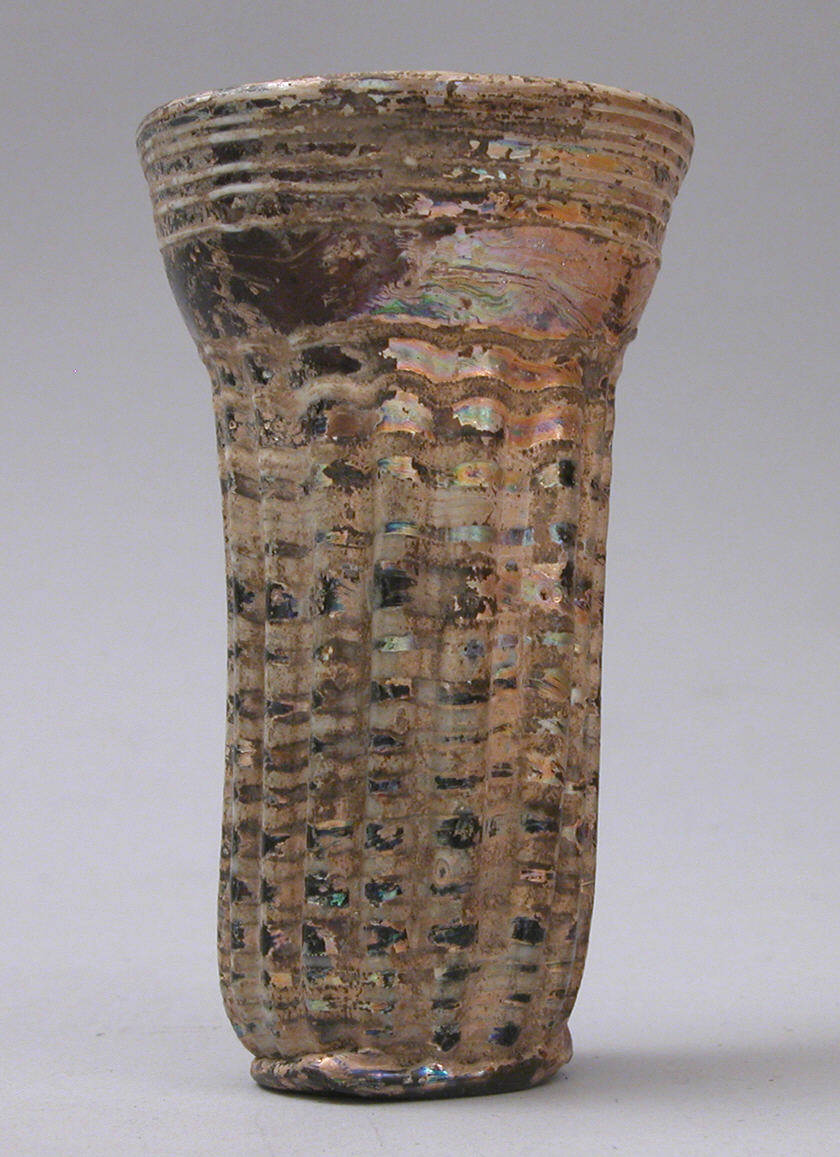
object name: beaker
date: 1201-1400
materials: glass, thread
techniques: glassblowing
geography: syria